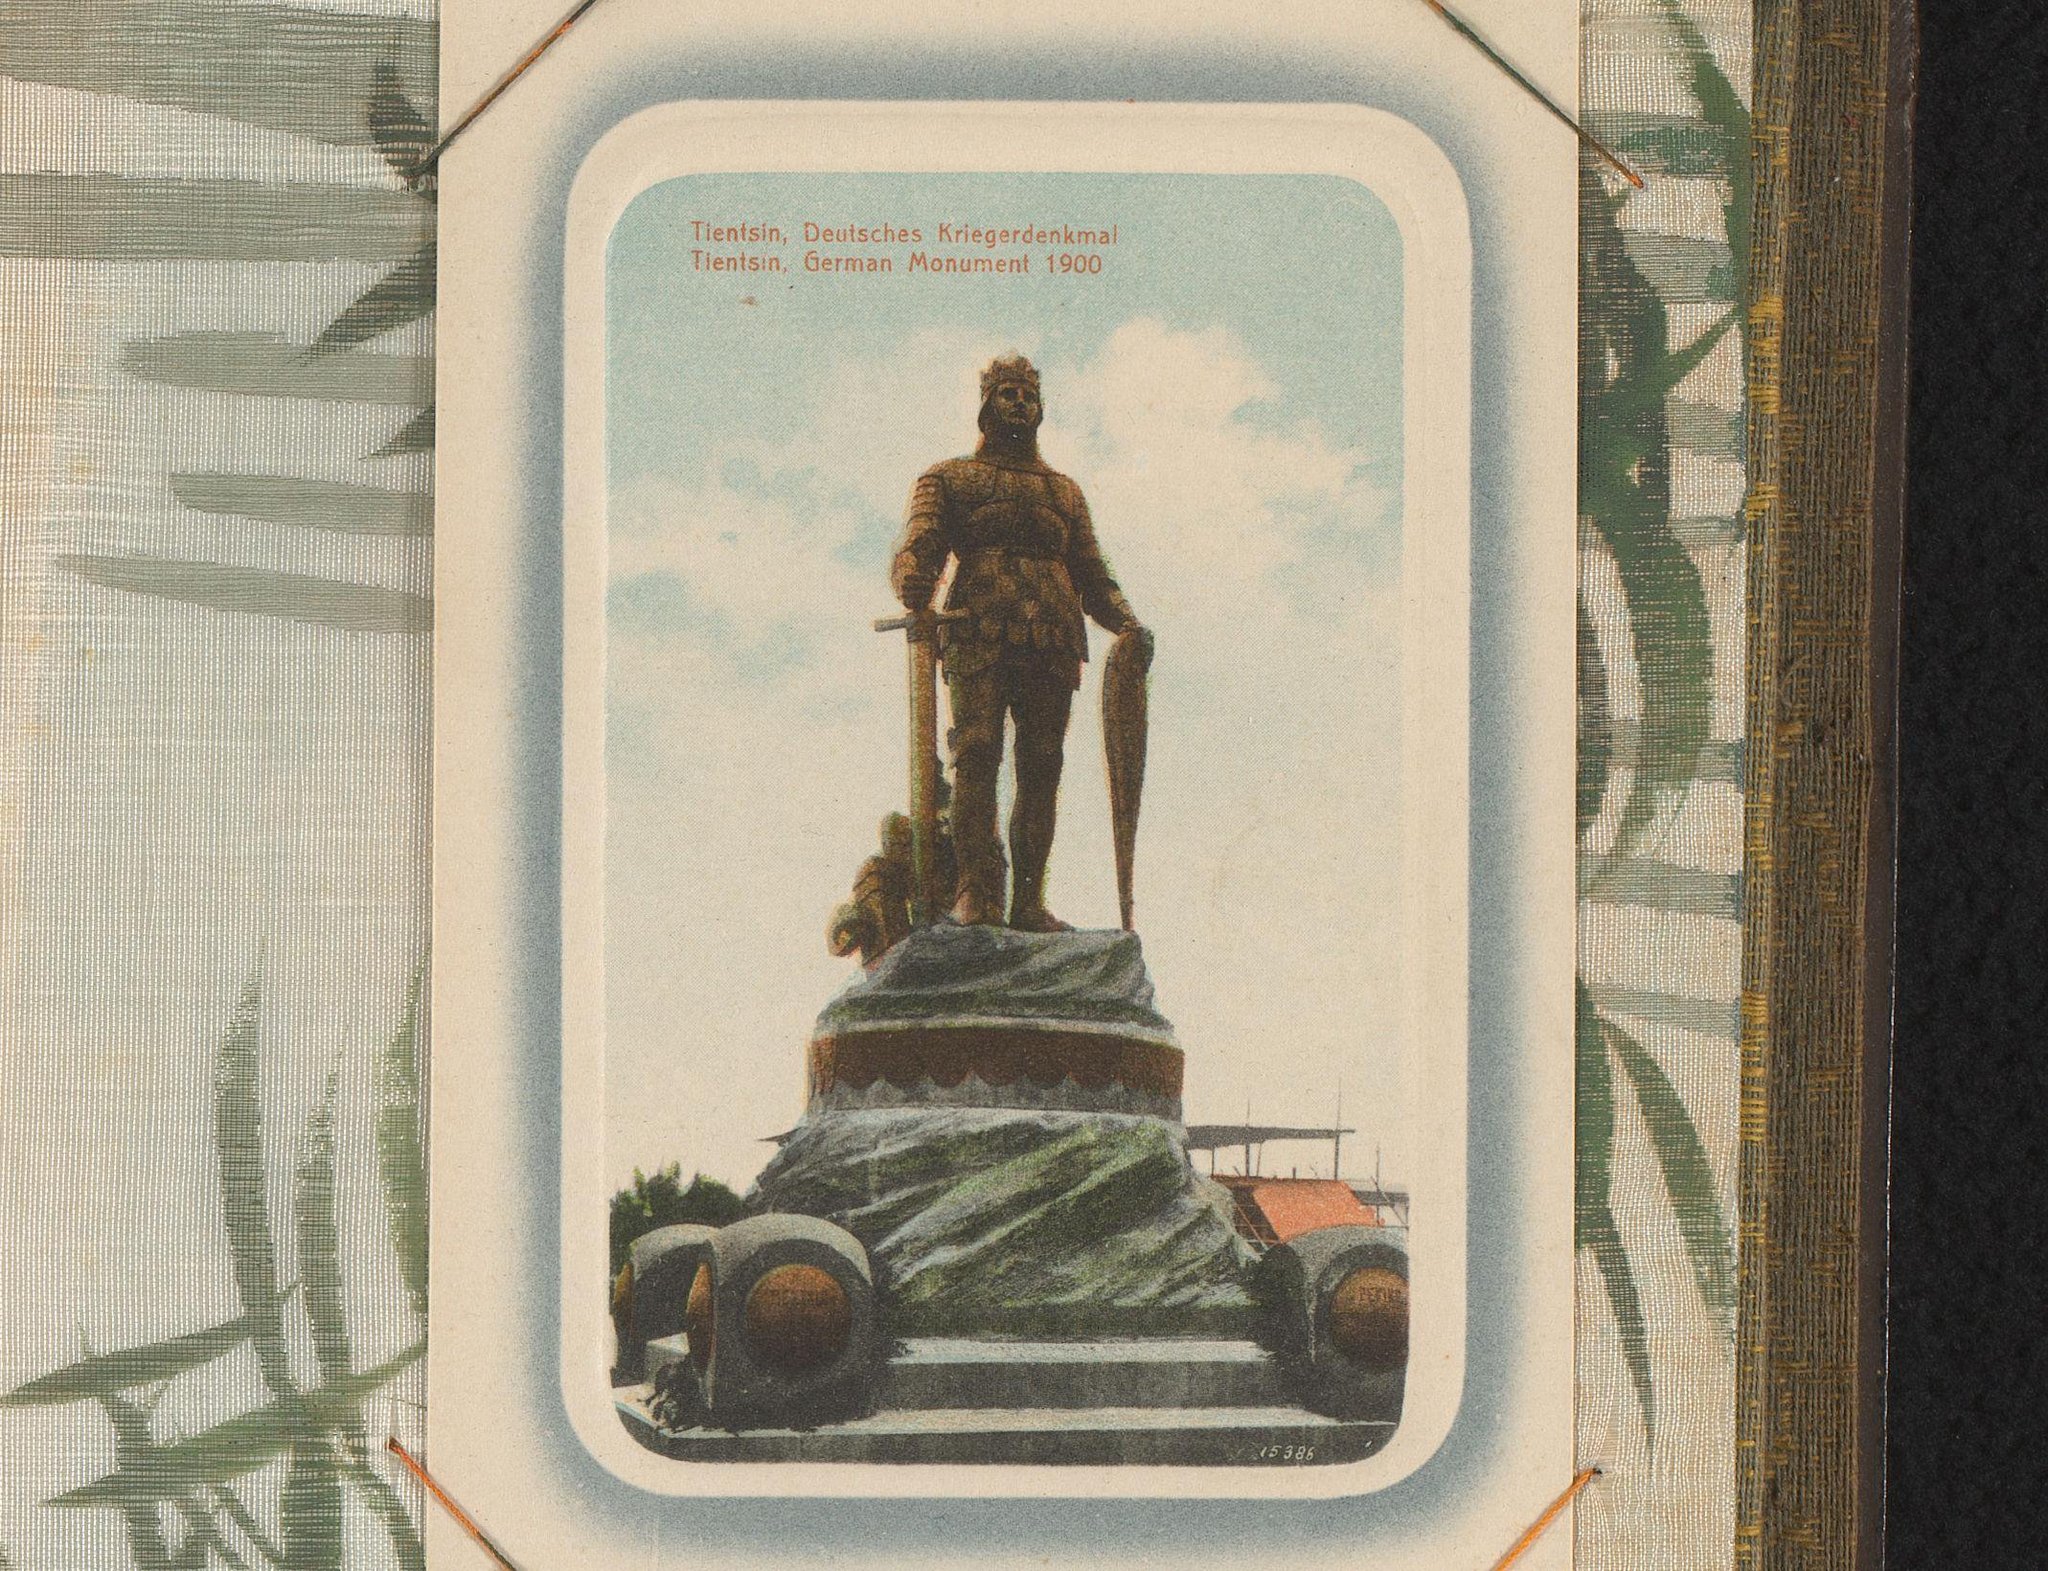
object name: ansichtkaart, prentbriefkaart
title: Tientsin, Deutsches Kriegerdenkmal / Tientsin, German Monument 1900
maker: Anonymous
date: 1900-1920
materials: paper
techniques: chromolithography, photograph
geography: tianjin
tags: monument, statue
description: Deze prent maakt deel uit van een album.